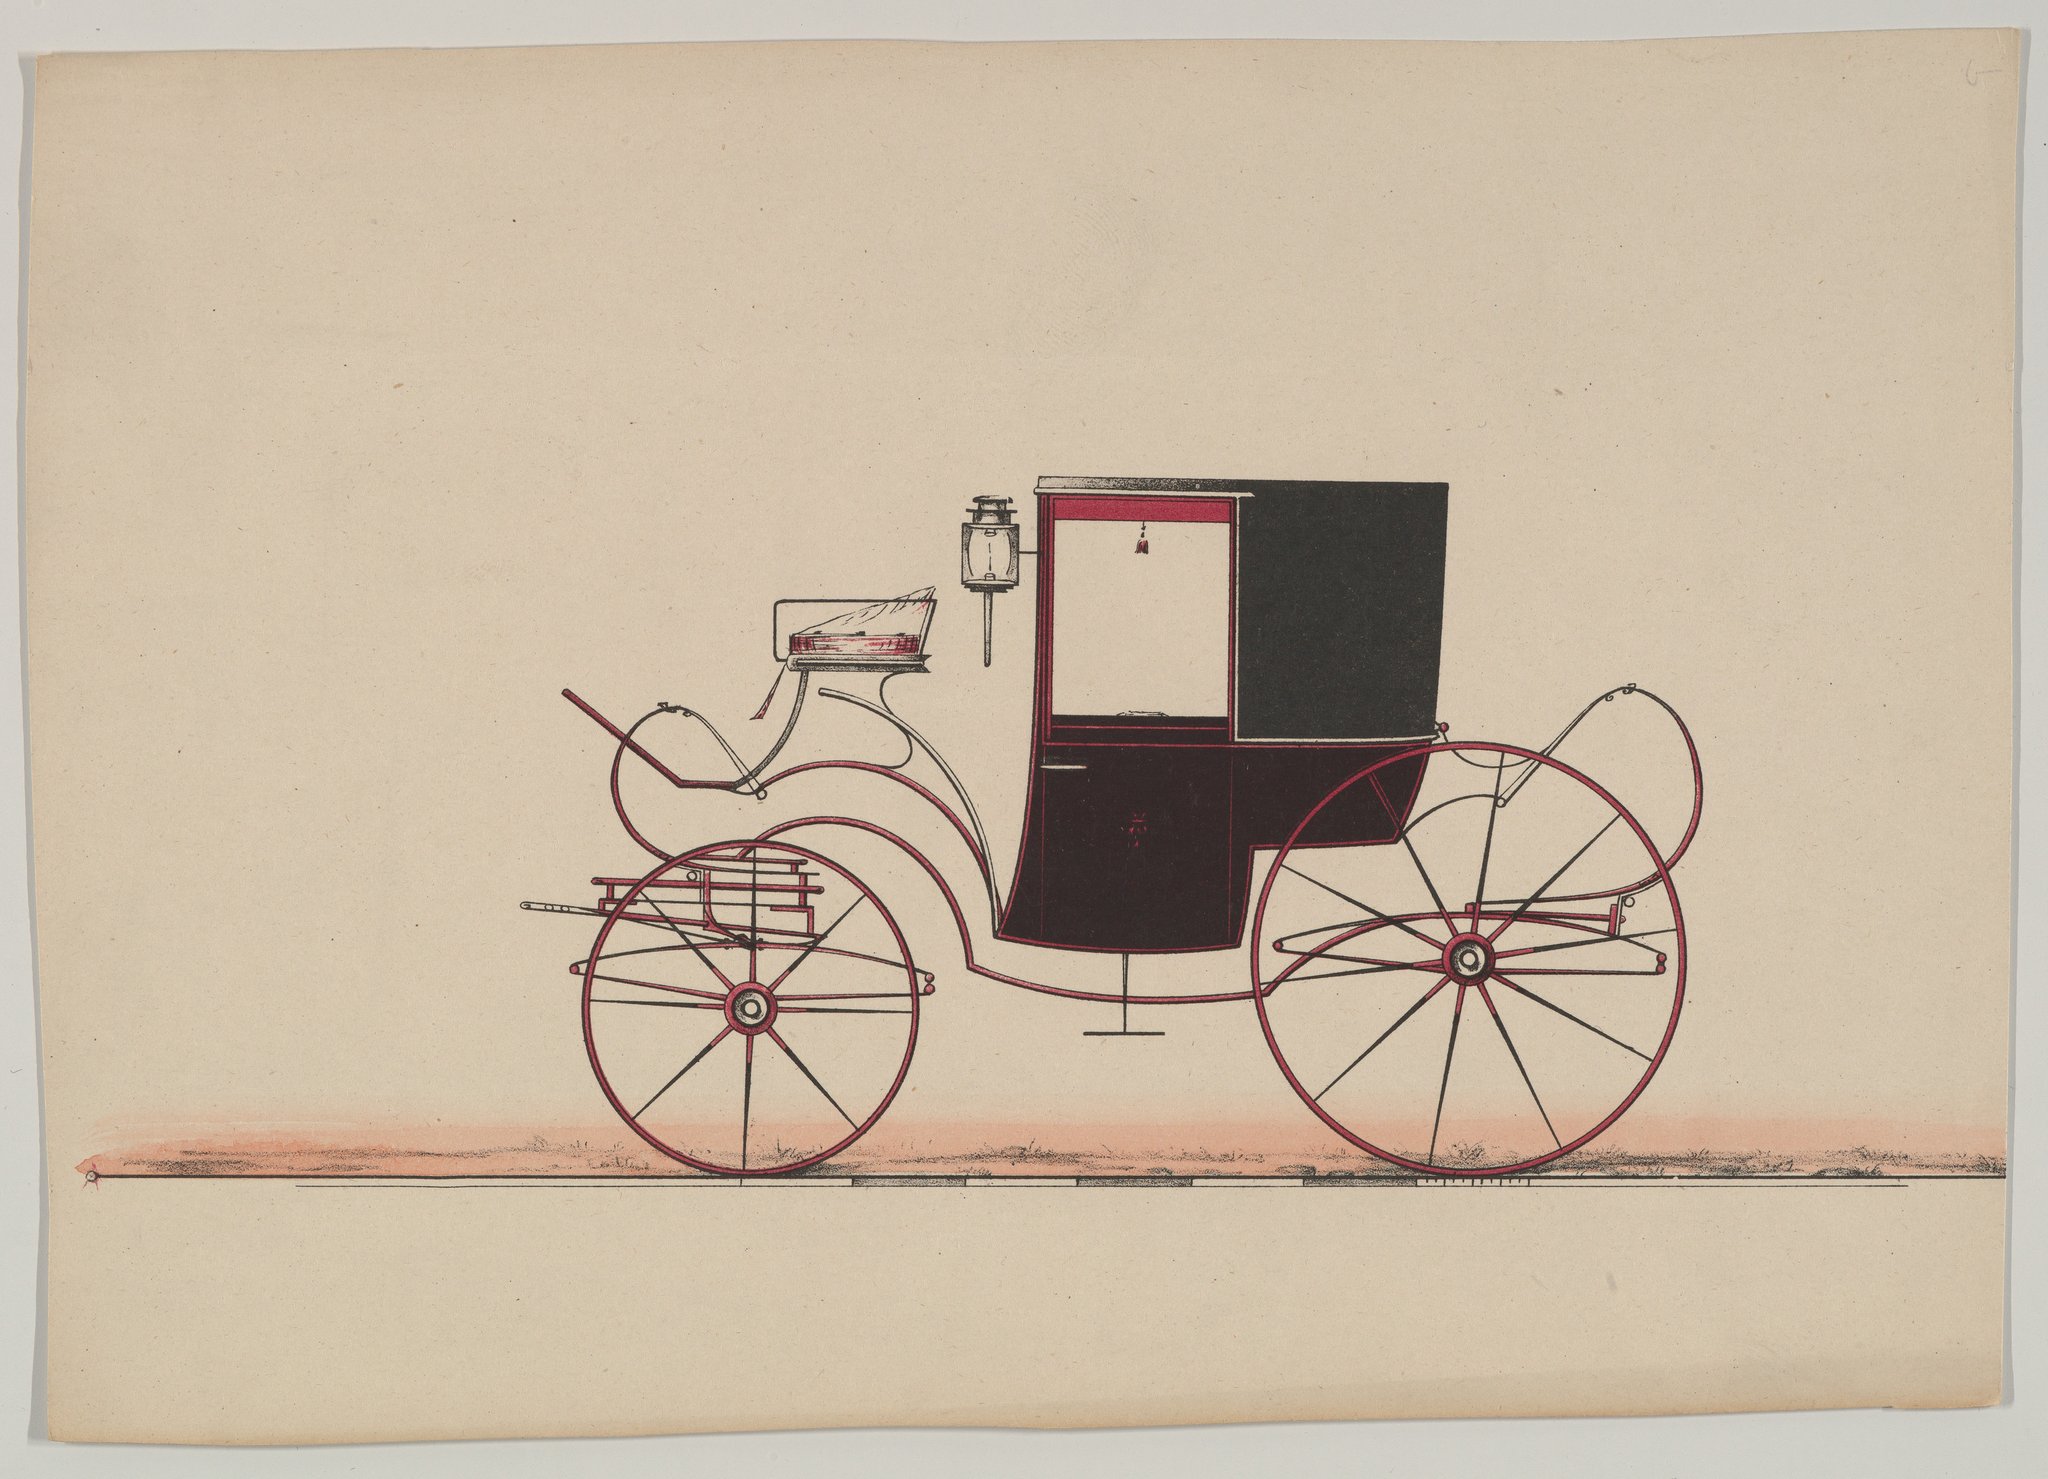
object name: print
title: Coupe (unnumbered)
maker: brewster & co.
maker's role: manufacturer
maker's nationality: american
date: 1850-1870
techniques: lithograph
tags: carriages